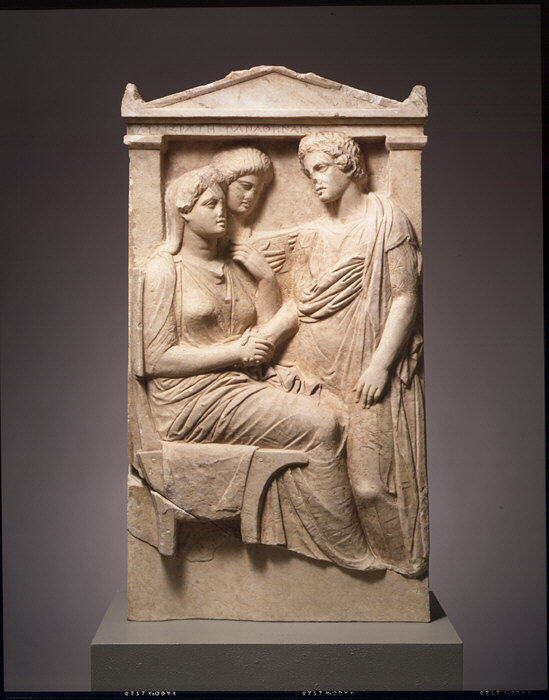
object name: grave stele of lysistrate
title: Marble stele (grave marker) of Lysistrate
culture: greek, attic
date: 350-325 BCE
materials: marble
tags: mothers,women